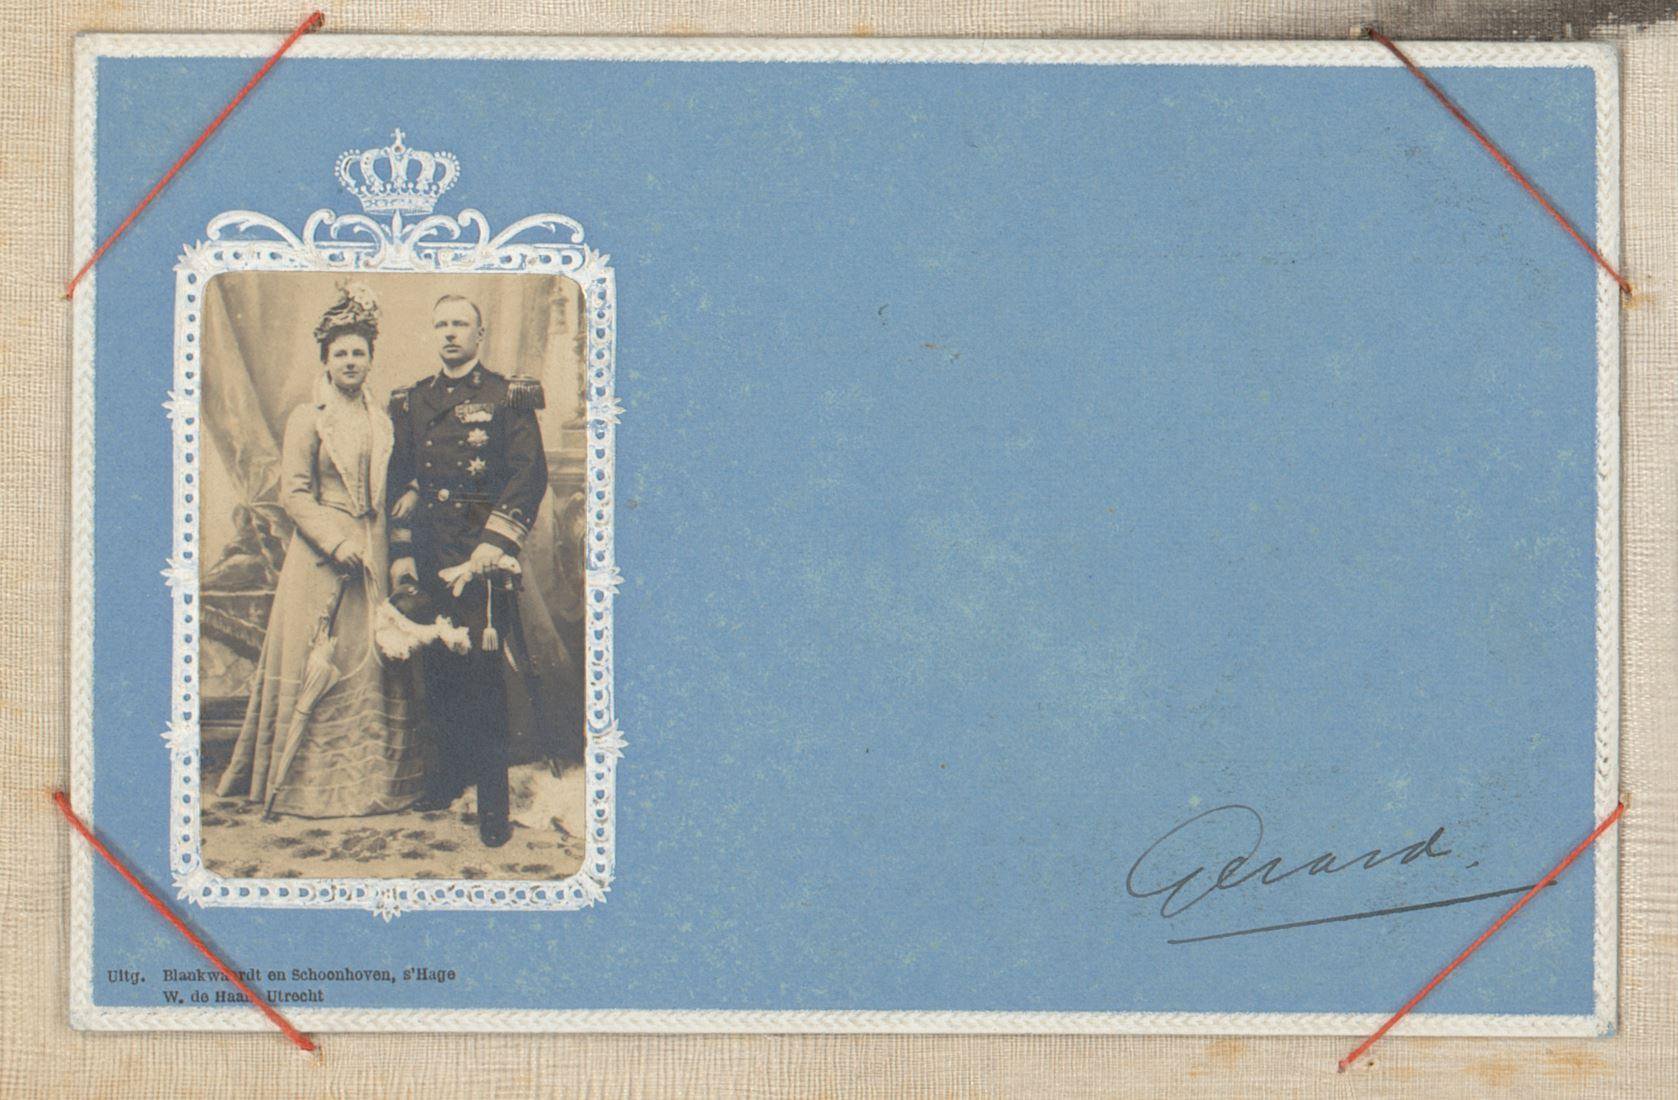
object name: album leaf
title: Portret van Wilhelmina en Hendrik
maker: Anonymous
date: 1900-1920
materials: cardboard, paint, photographic support, silk, textile, watercolor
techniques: blind stamped, brush, gelatin silver print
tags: the hague, print maker, wilhelmina of the netherlands, hendrik (prins der nederlanden (1876-1934)), historical persons, queen, king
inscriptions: annotation: ‘Gerard’